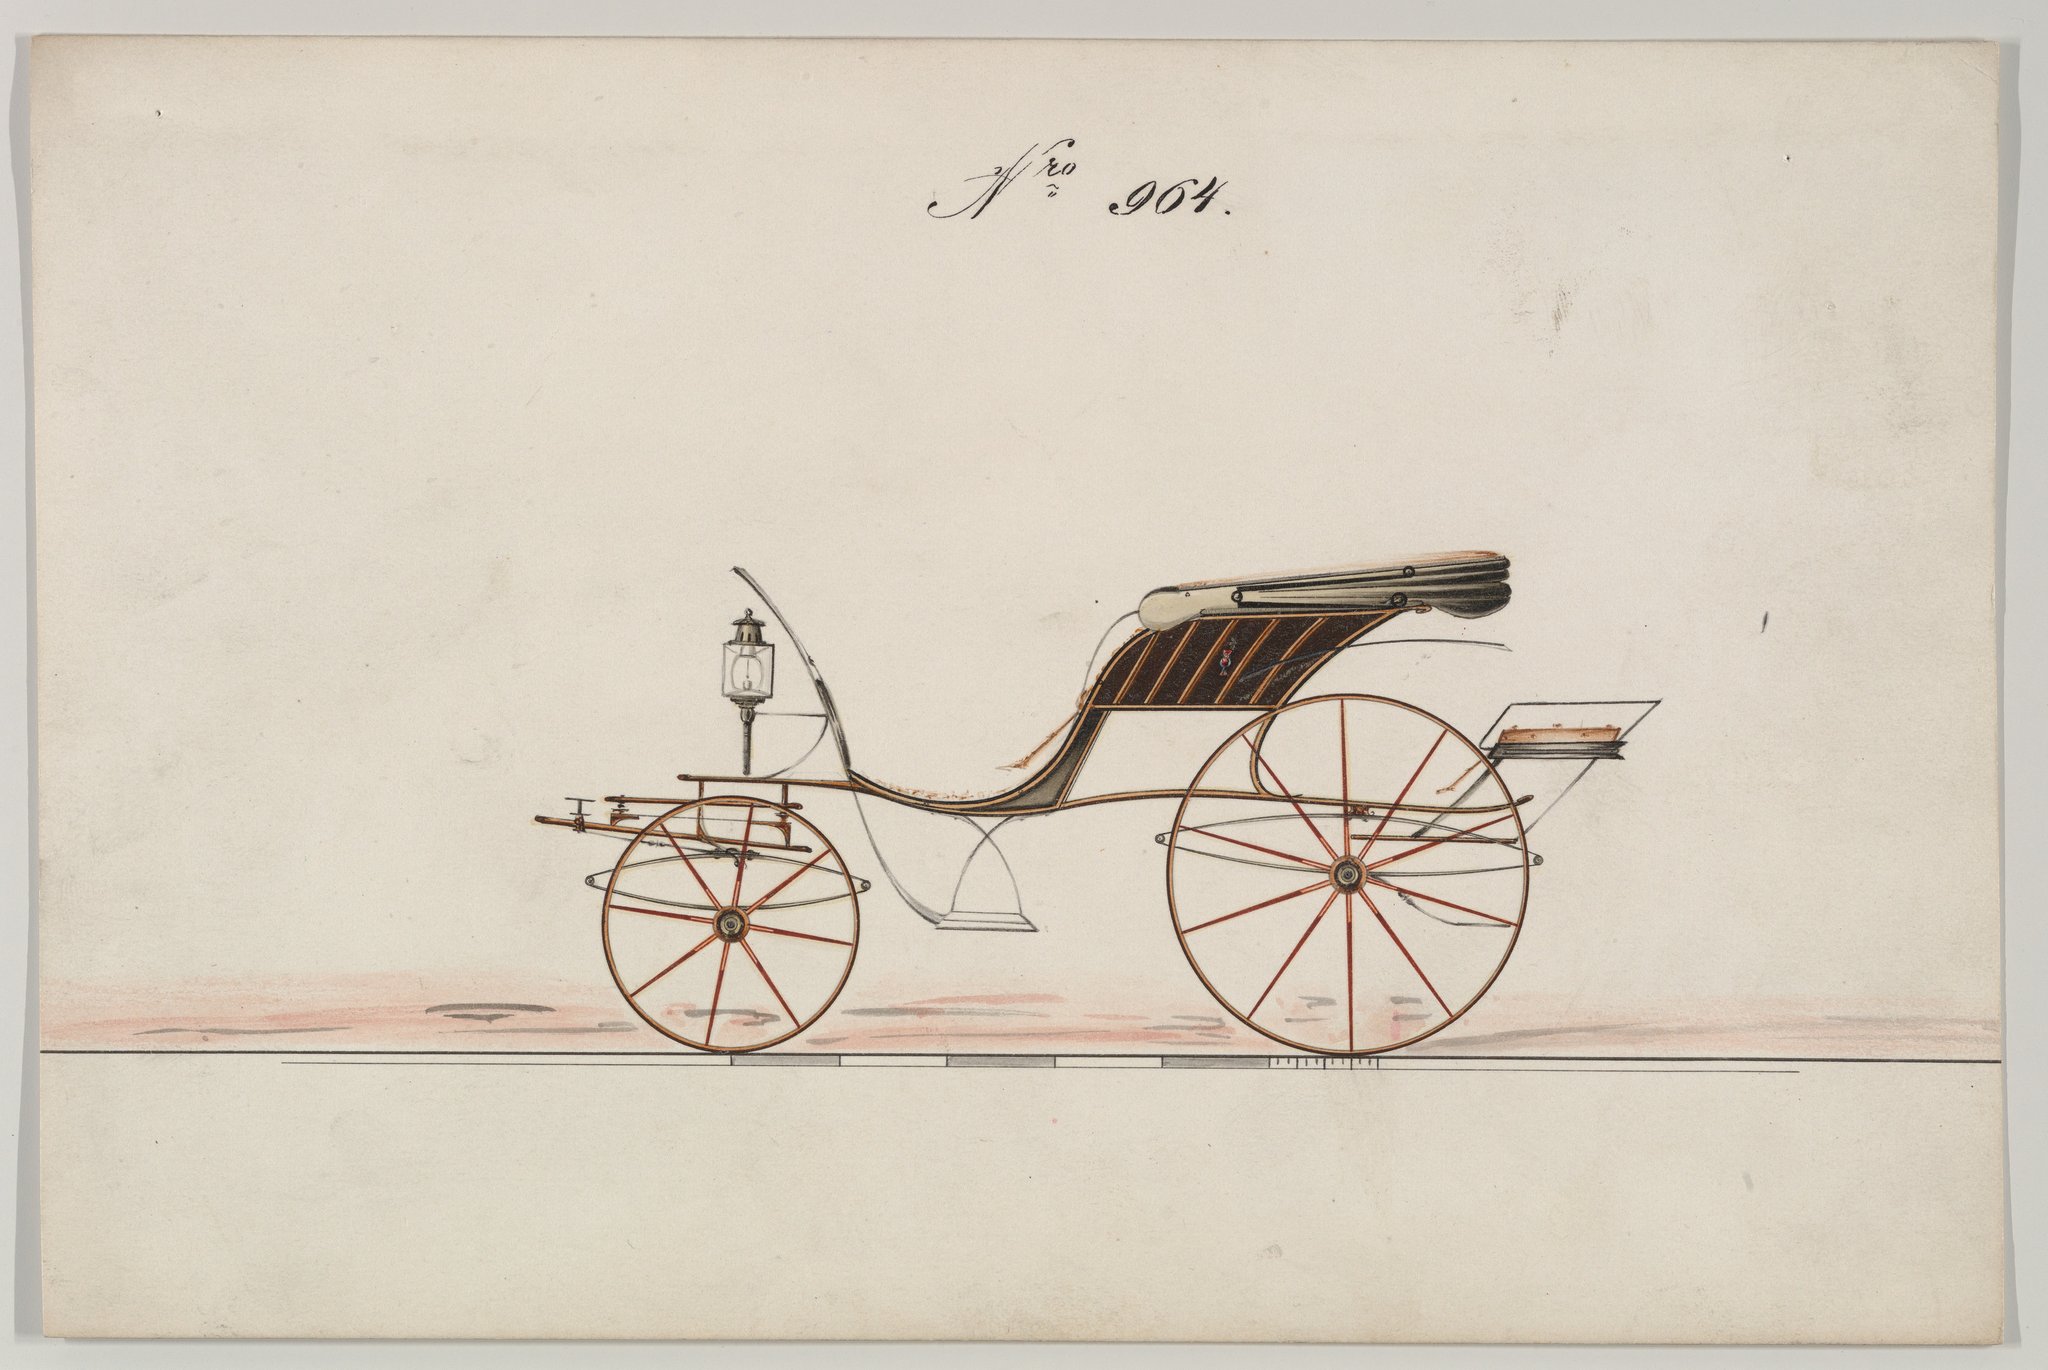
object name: drawing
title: Phaeton #964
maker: brewster & co.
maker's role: manufacturer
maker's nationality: american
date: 1870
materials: gouache, gum arabic, ink, watercolor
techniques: pen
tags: carriages